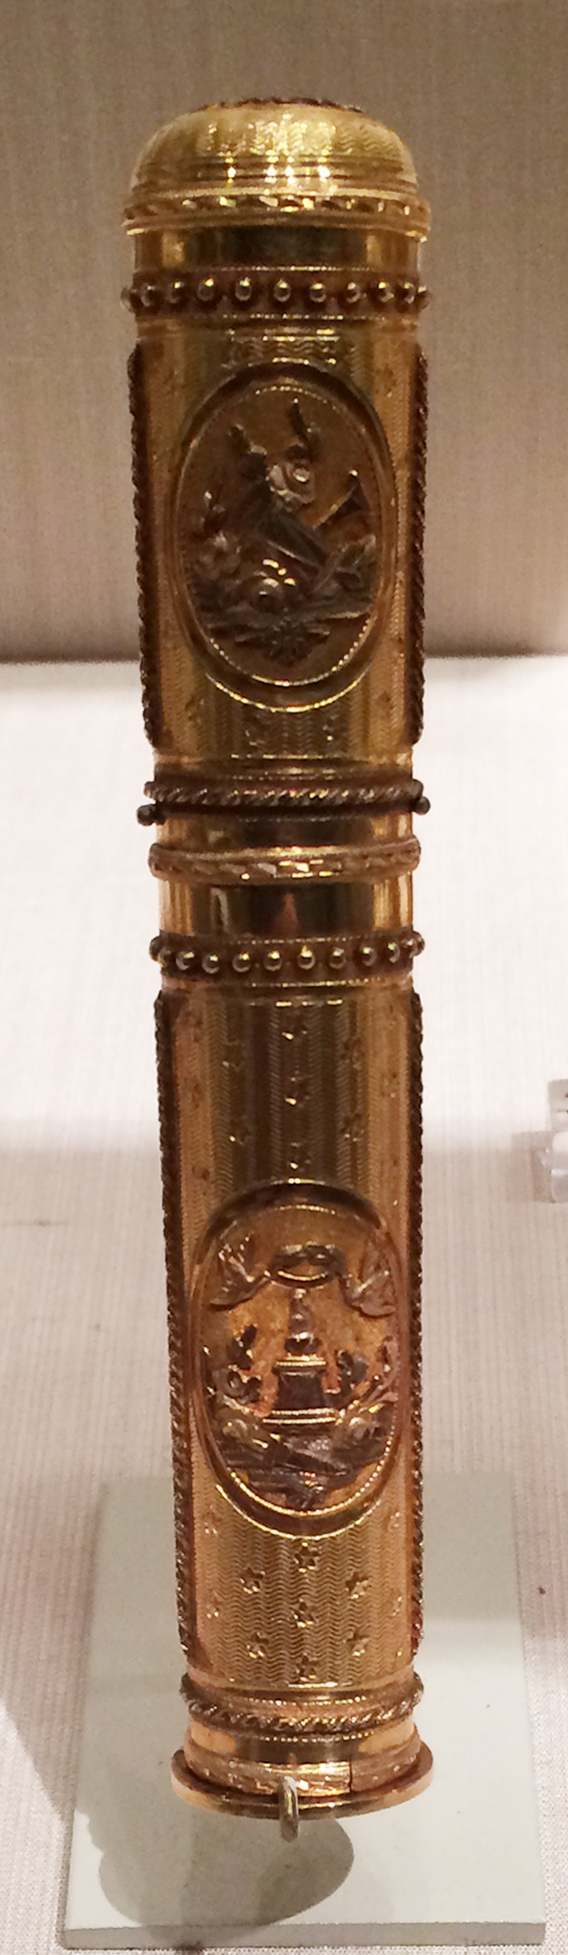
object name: étui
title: Sealing wax case (étui)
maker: nicolas-jean-baptiste choconain-delauney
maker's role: maker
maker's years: 1775-1793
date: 1782-1783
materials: gold